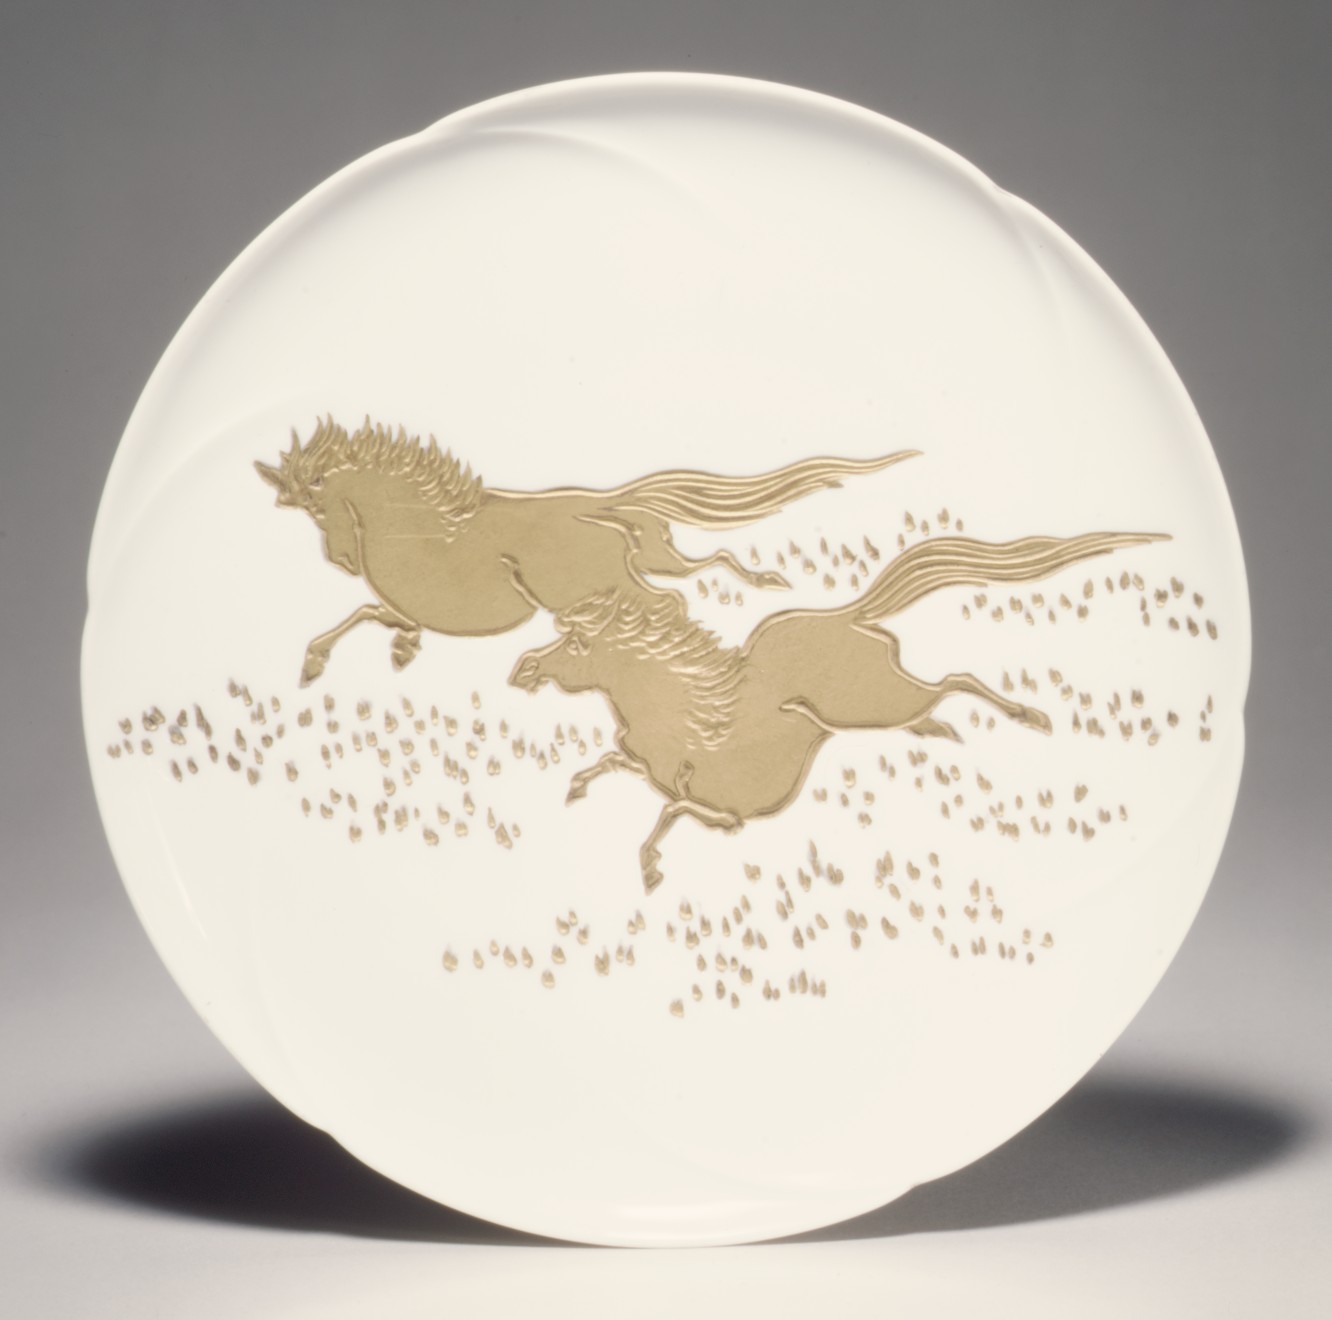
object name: plate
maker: félix bracquemond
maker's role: artist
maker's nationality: french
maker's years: 1833-1914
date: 1875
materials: porcelain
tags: horses